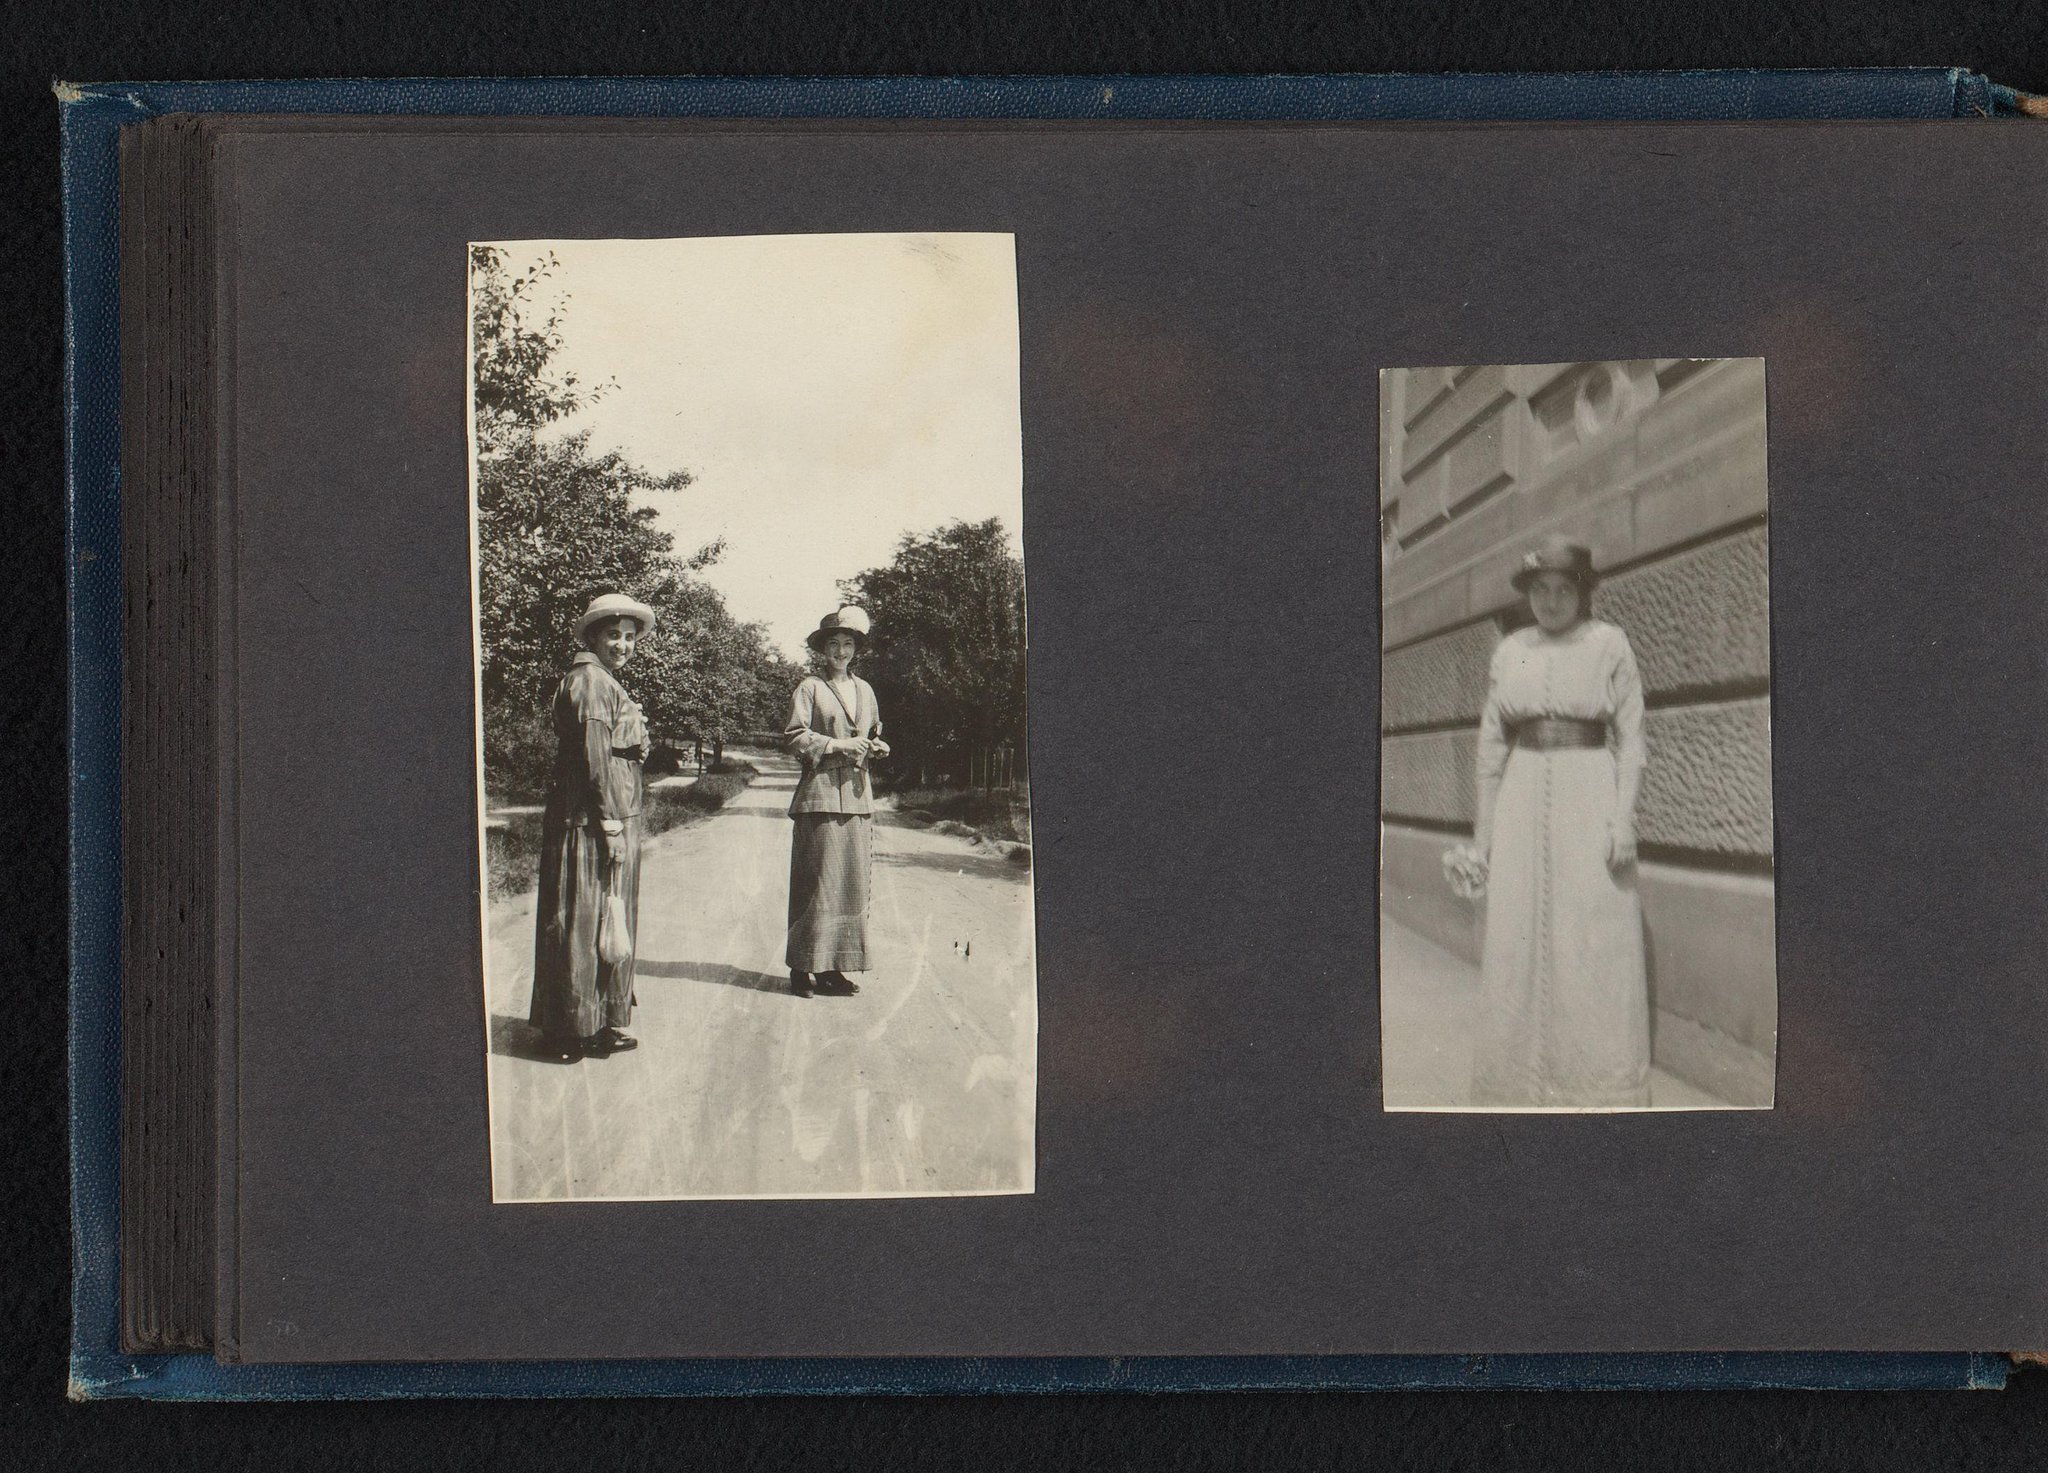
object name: photograph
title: Else en vriendin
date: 1914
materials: paper, photographic support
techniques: gelatin silver print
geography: germany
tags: else wachenheimer-moos, outing, pleasure trip, germany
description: Albumblad met twee foto's van Else met een vriendin en van Else voor het huis in Stuttgart. Onderdeel van het fotoalbum van Else Wachenheimer-Moos en haar broers Arthur en Willy Moos en anderen in de periode 1913-1918.